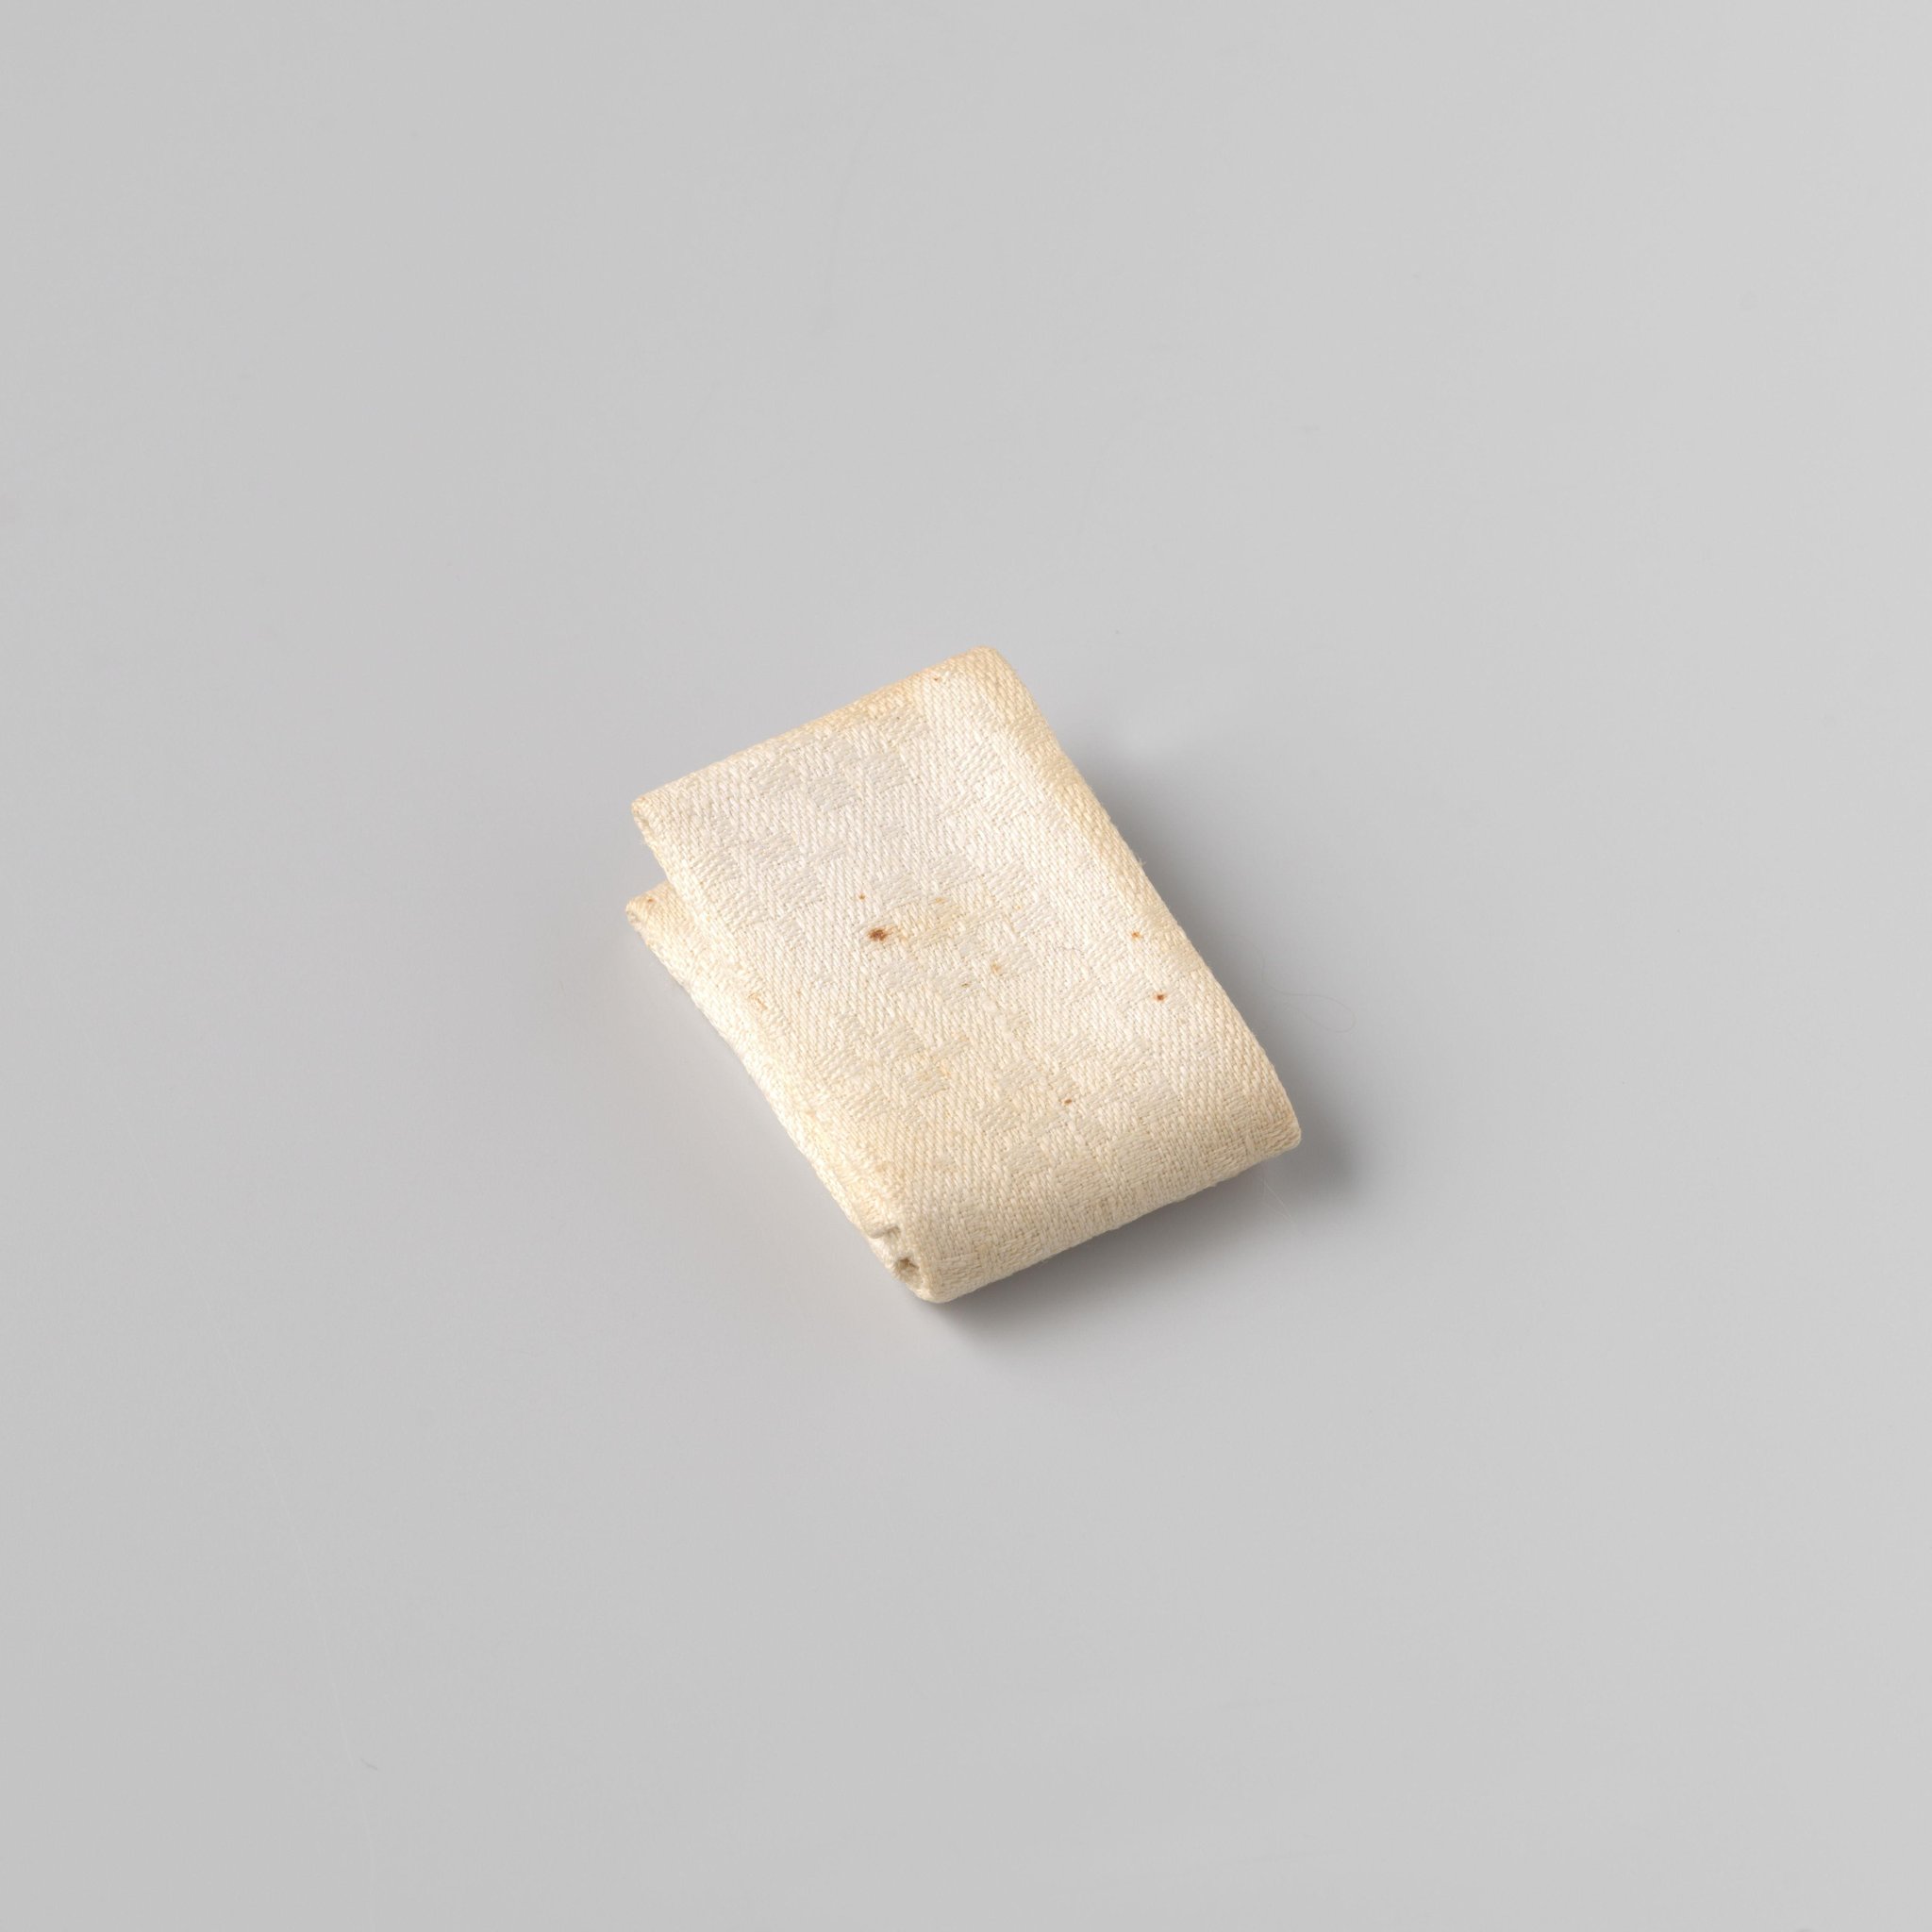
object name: napkin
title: Linnen servet van damastweefsel met pellenpatroon (motief II), aan vier zijden omzoomd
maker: Anonymous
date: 1690-1710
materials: linen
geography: haarlem